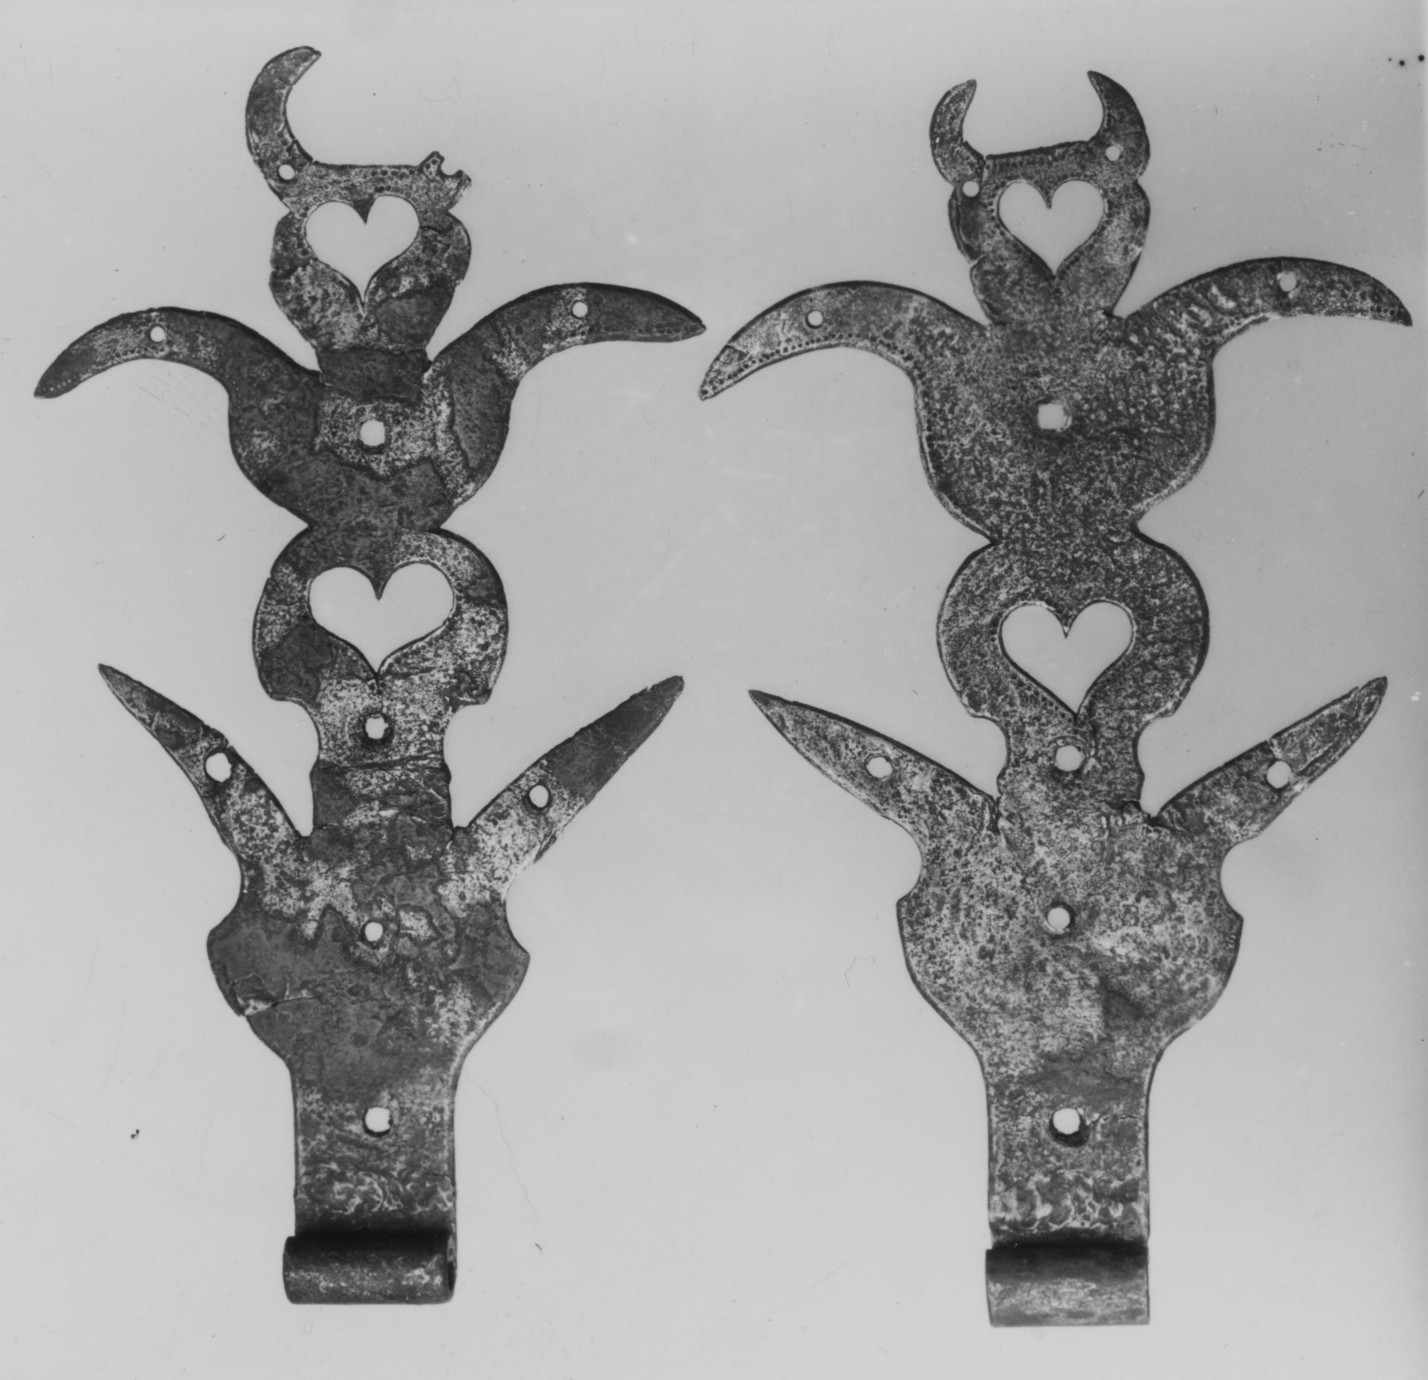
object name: hinge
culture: american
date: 1700-1800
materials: iron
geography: united states